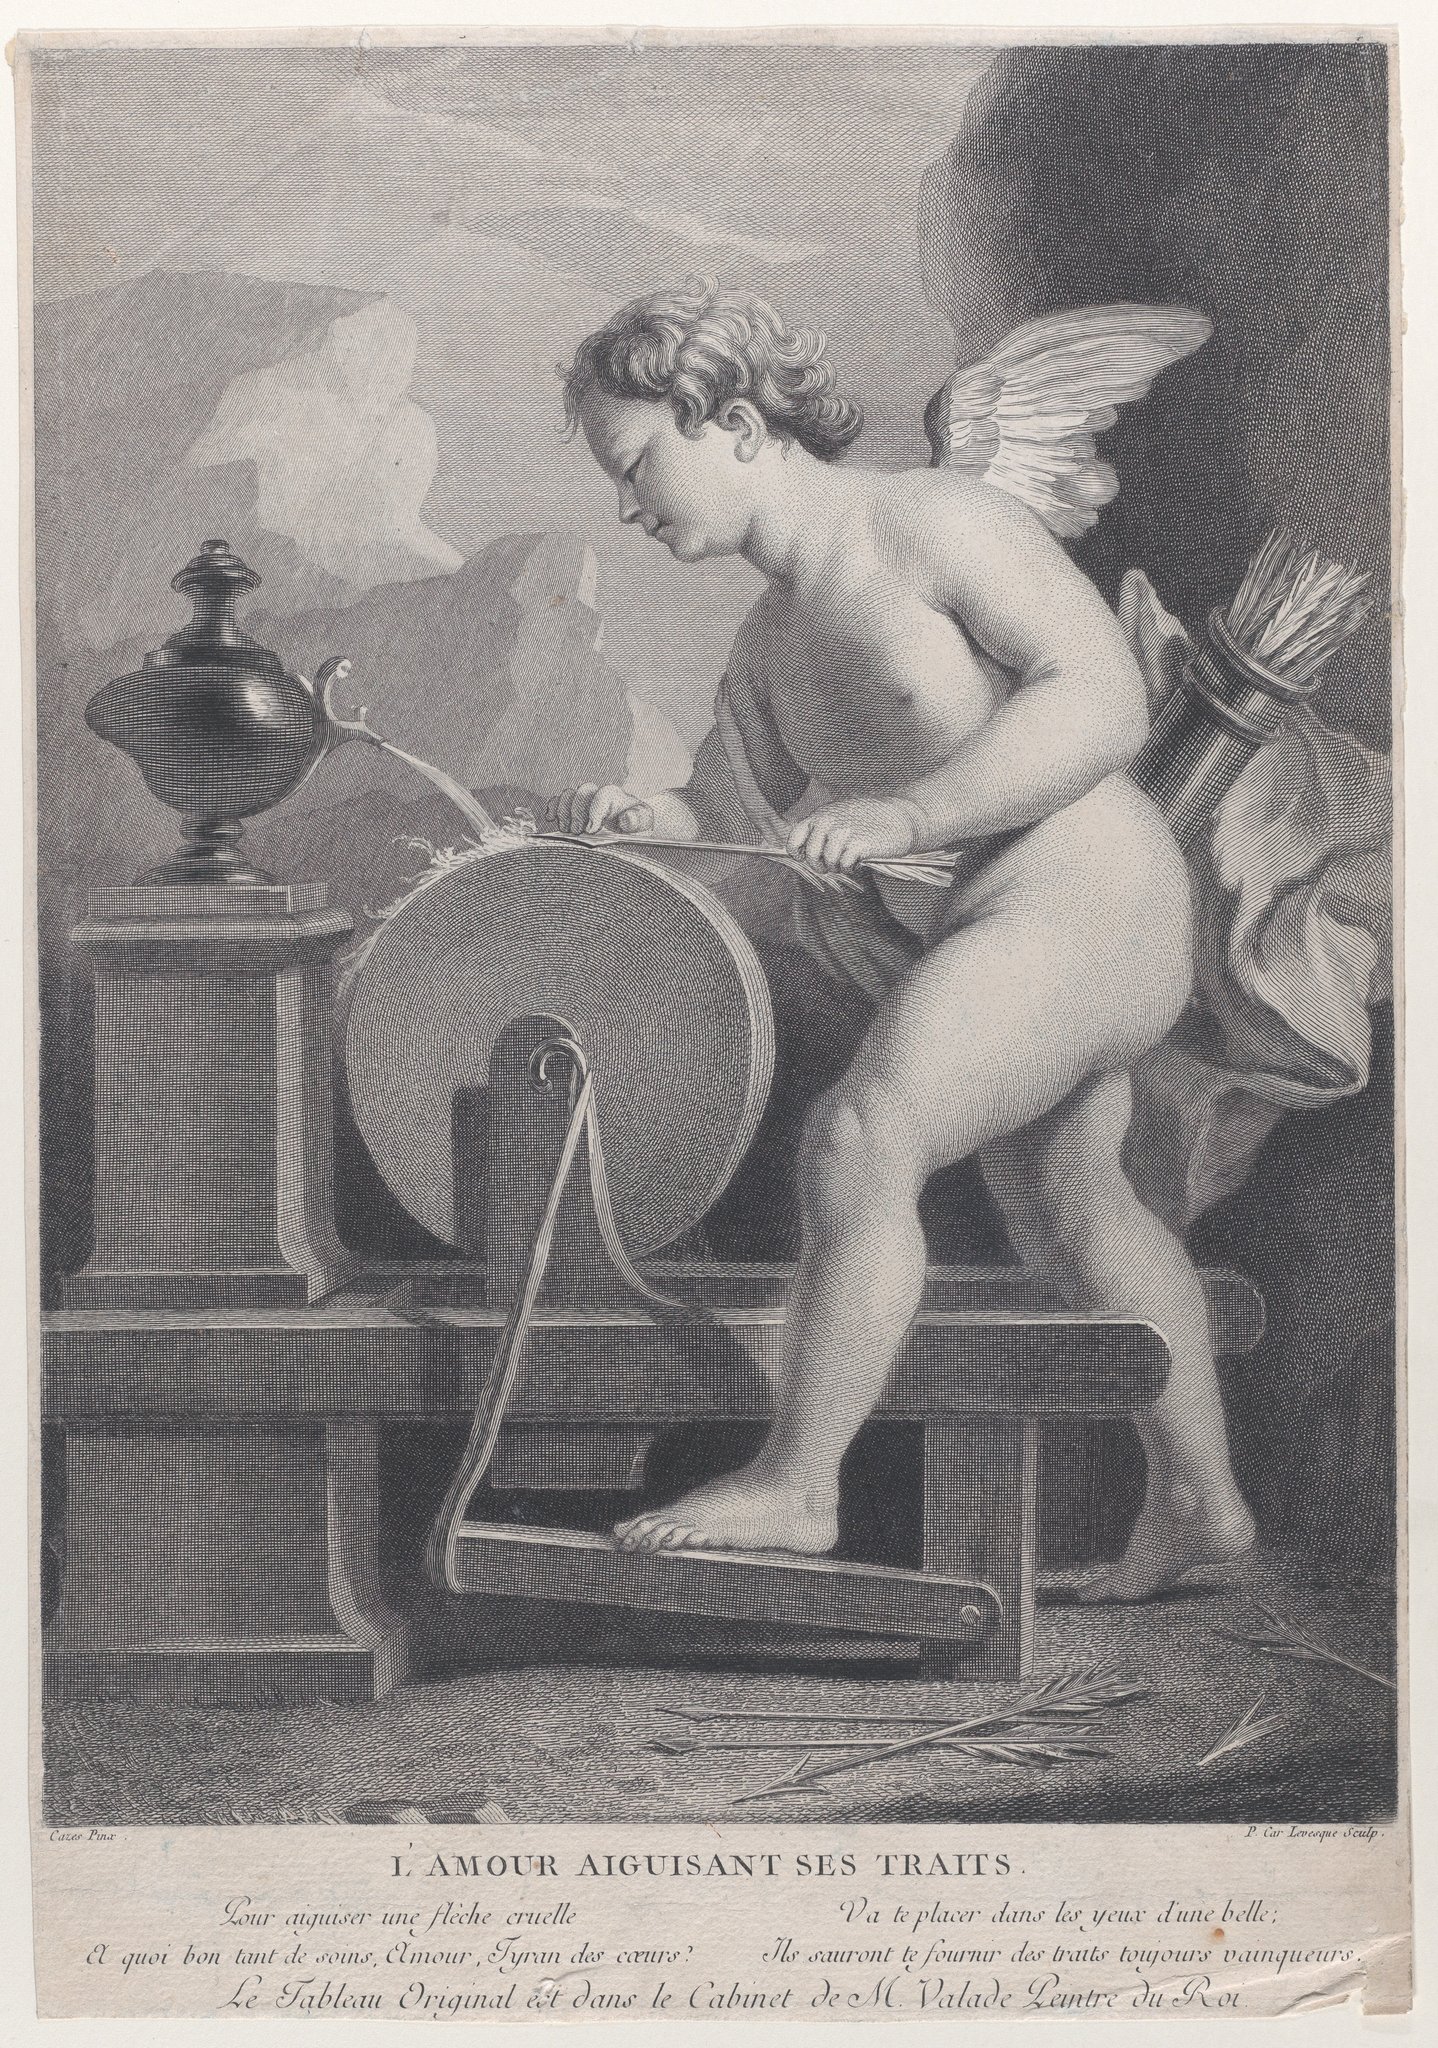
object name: print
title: Cupid Sharpening His Arrows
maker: pierre charles lévesque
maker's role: artist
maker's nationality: french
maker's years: 1736-1812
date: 1770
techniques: engraving, etching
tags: arrows,cupid,tools